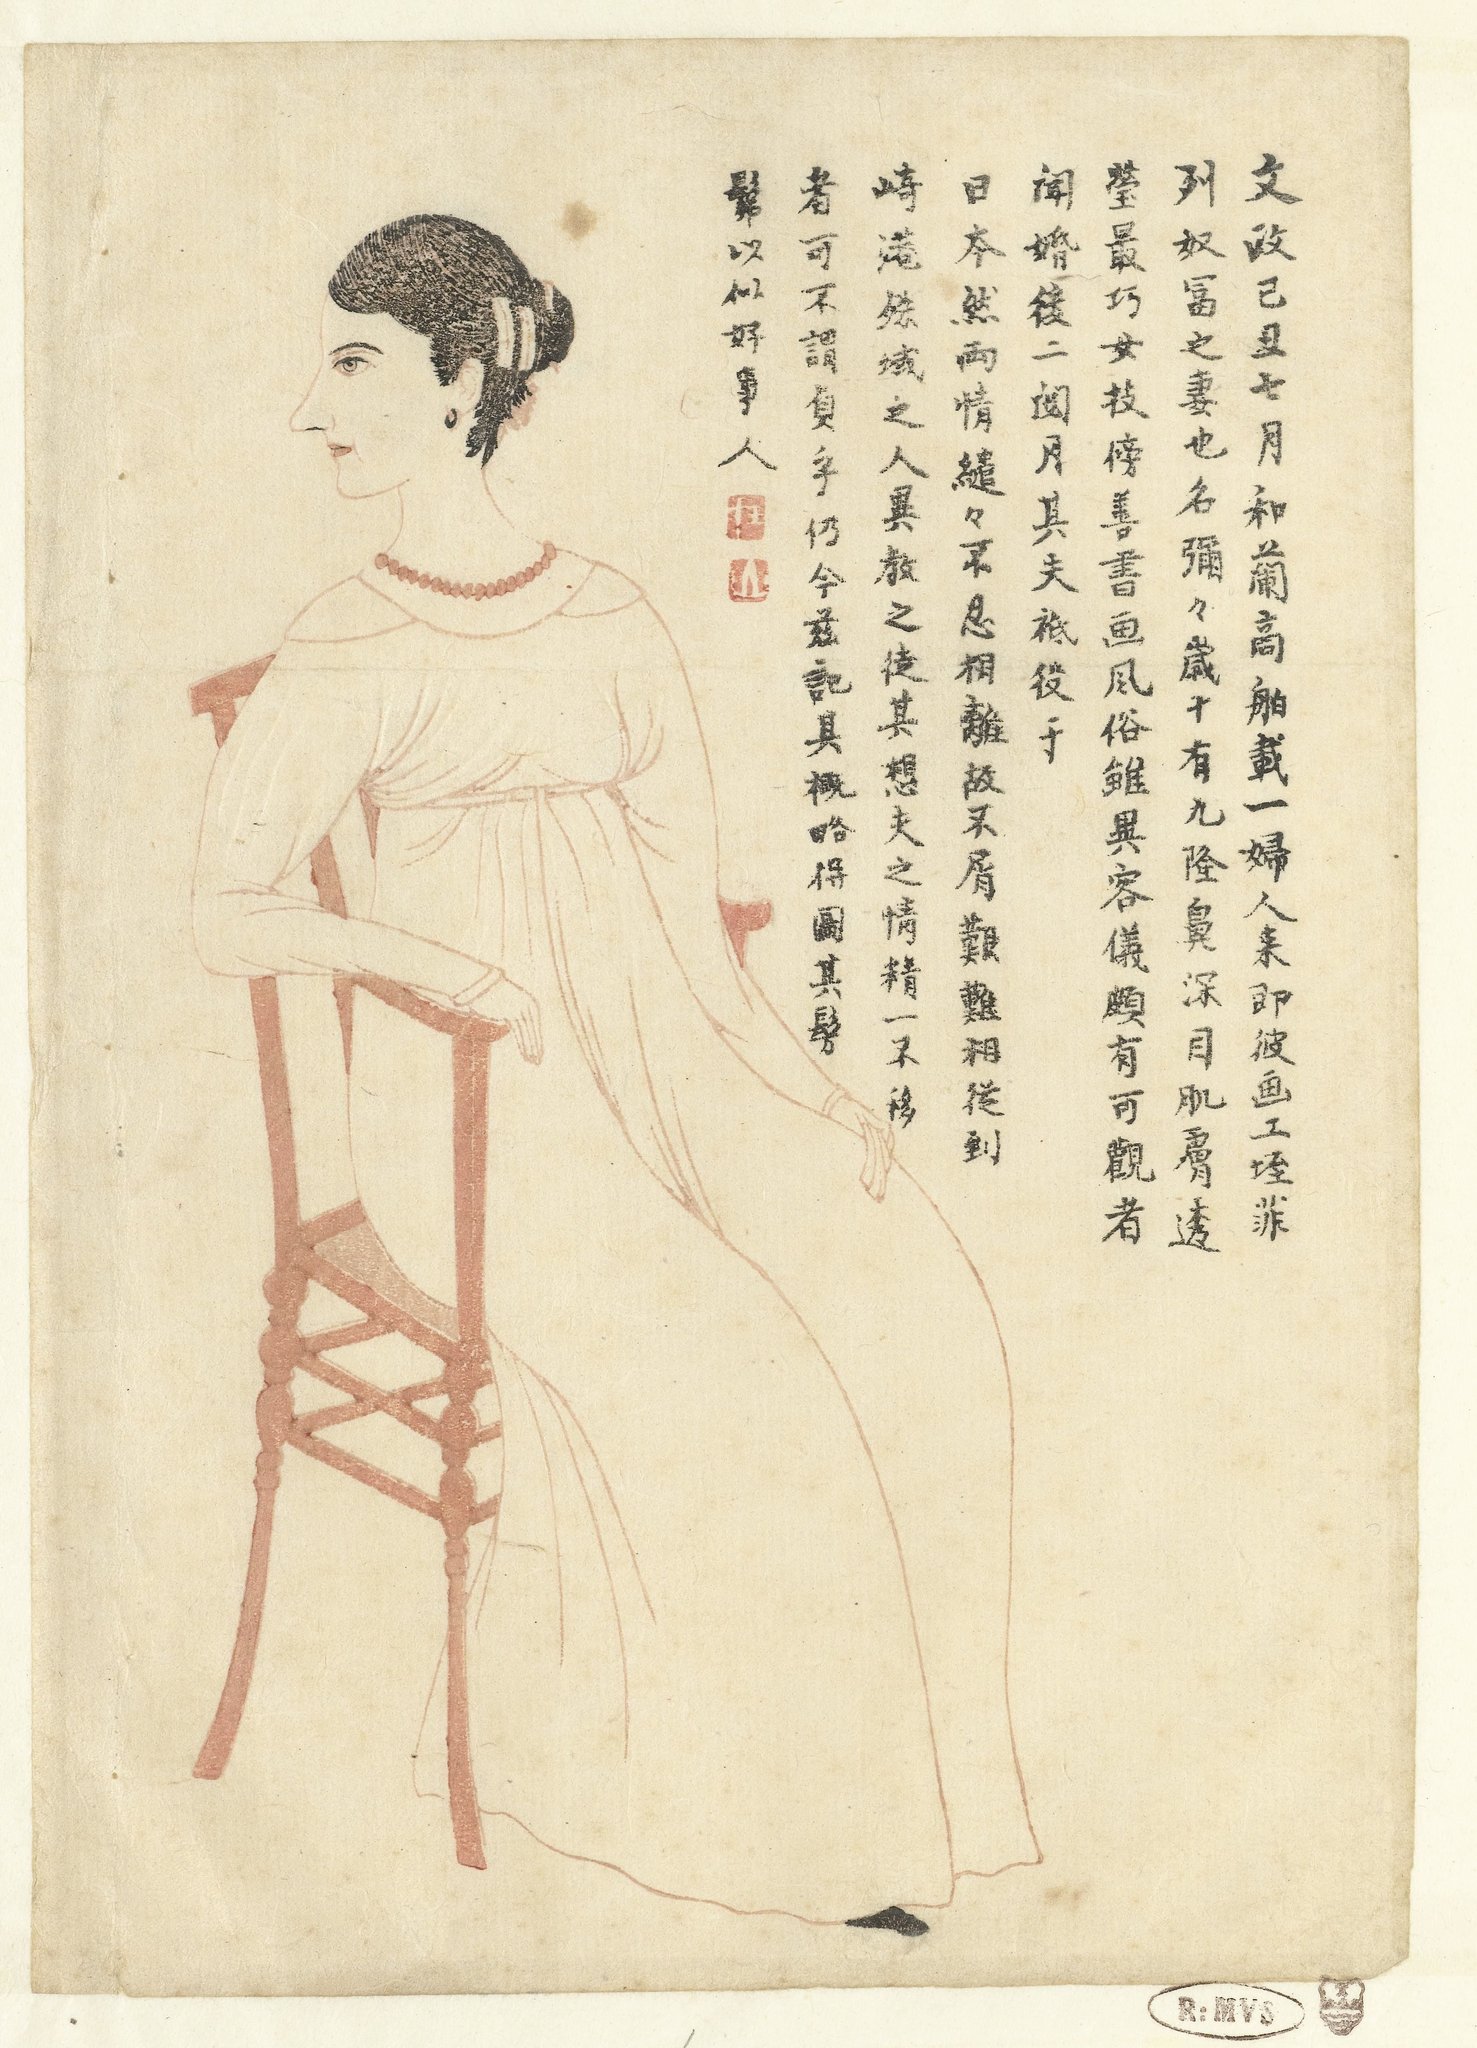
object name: print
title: Mimi de Villeneuve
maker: isono bunsai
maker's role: print maker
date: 1829-1832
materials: paper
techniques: blind stamped, woodcut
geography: nagasaki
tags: historical persons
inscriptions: collector's mark: Lugt 2760, collector's mark: Lugt 2228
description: In 1829, Mimi de Villeneuve came to Nagasaki in the company of her husband. However, European women were not allowed to enter Deshima, the Dutch trading colony and she had to turn back straightaway on the ship she had come on. Although she was not permitted to disembark, pictures were made of her. The text describes her appearance – highlighting her deep-set eyes, transparent skin and long nose – which struck the Japanese as peculiar.